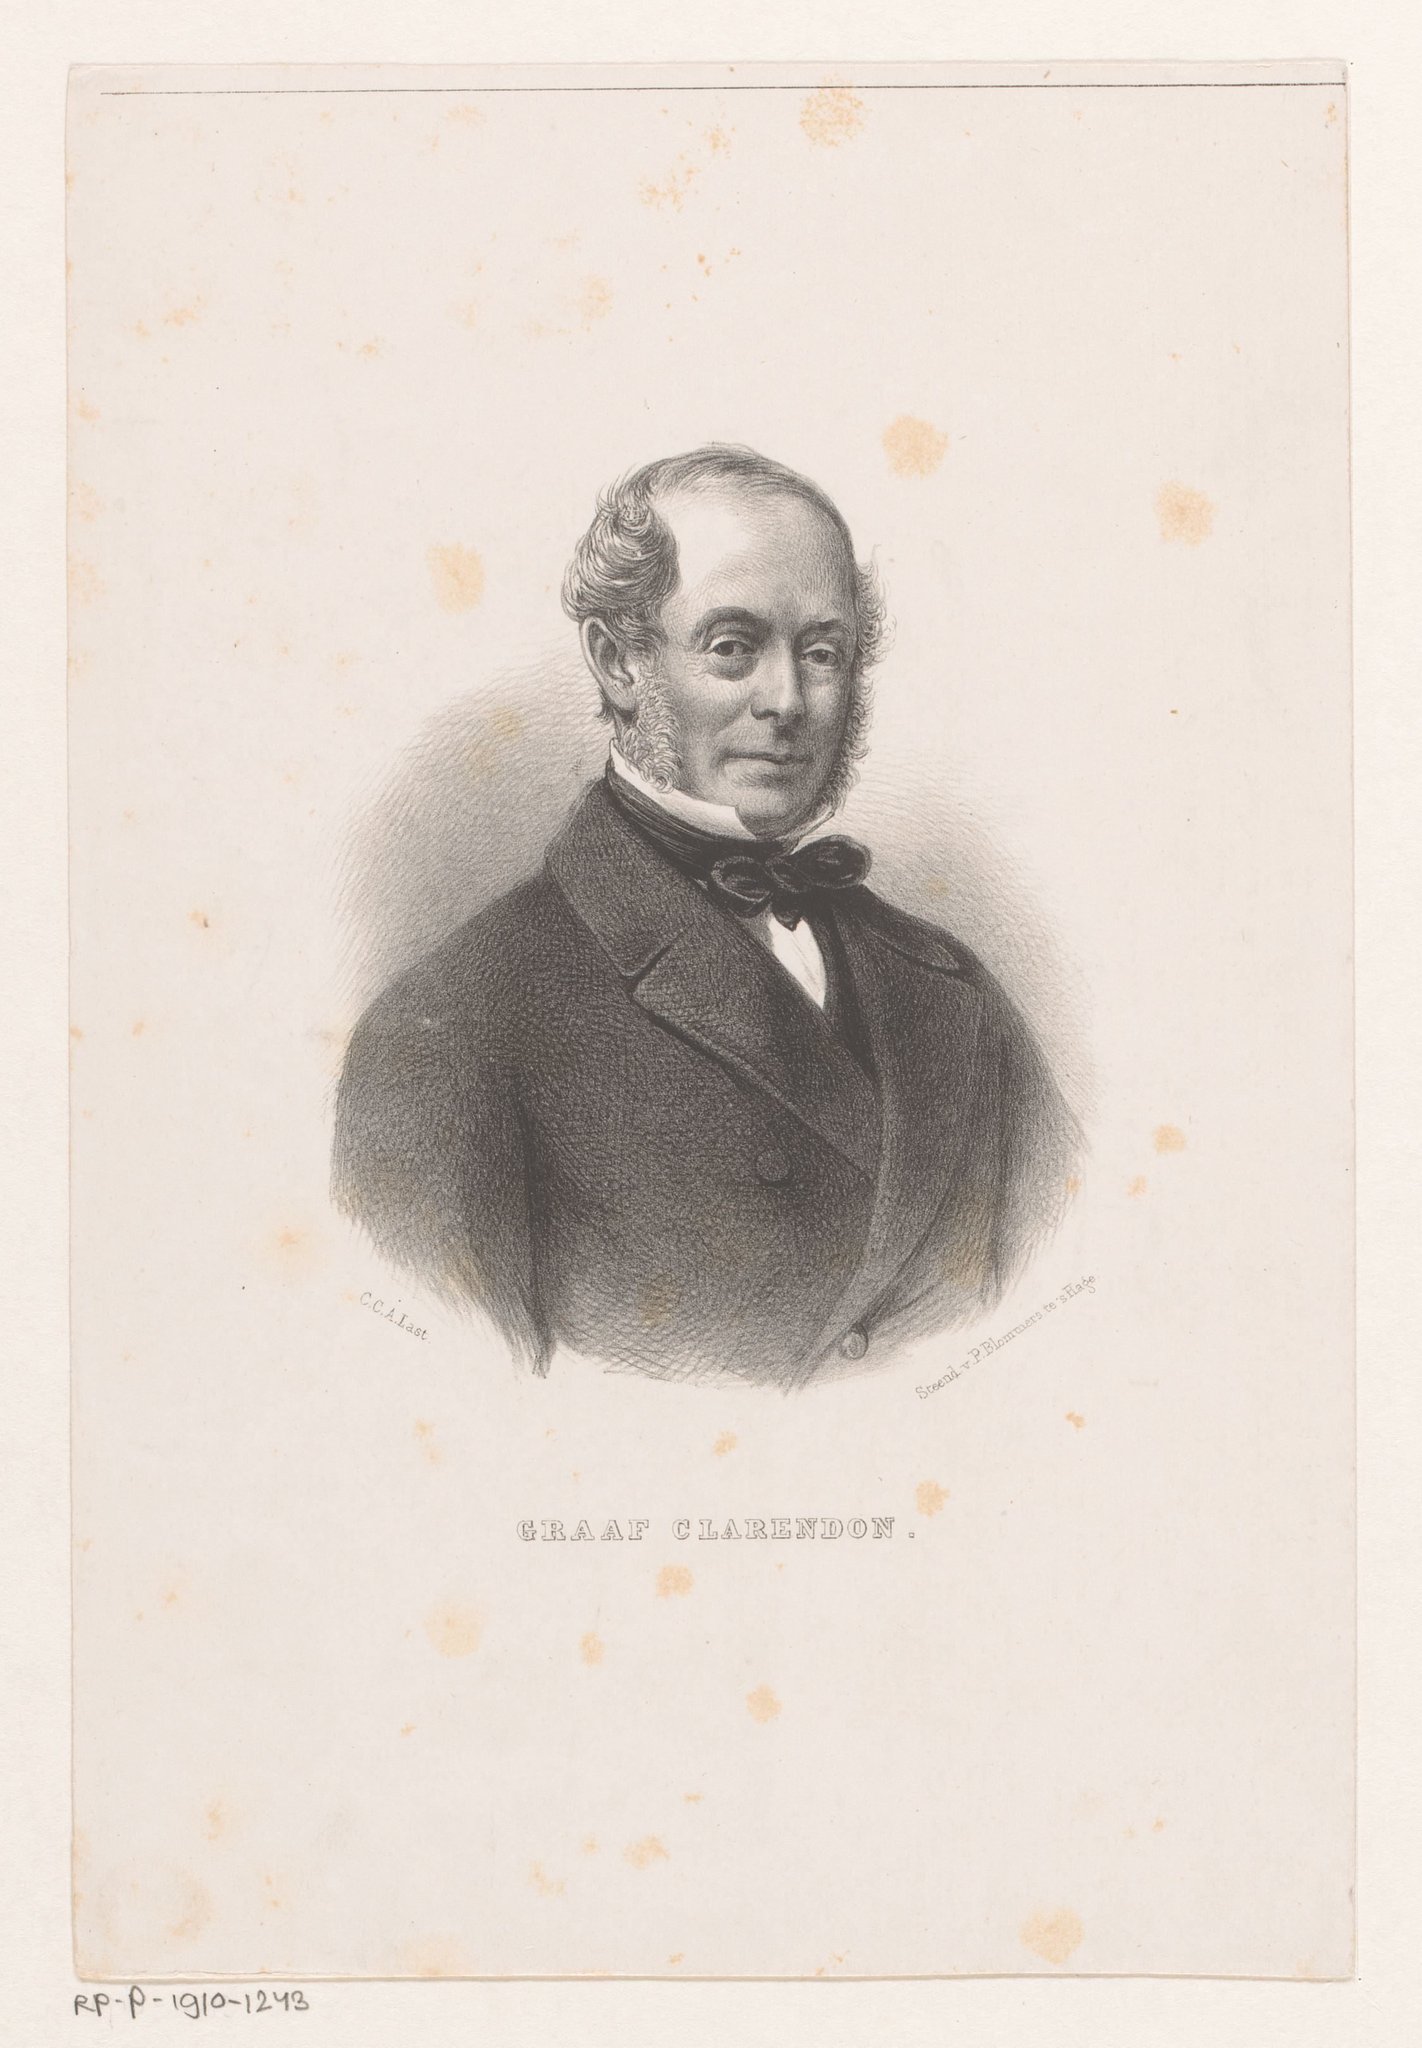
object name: print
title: Portret van de graaf van Clarendon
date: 1842-1887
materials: paper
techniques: lithograph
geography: the hague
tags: historical persons (+ (full) bust portrait)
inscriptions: collector's mark: Lugt 2228, inscription: ‘Leeskabinet 1866’